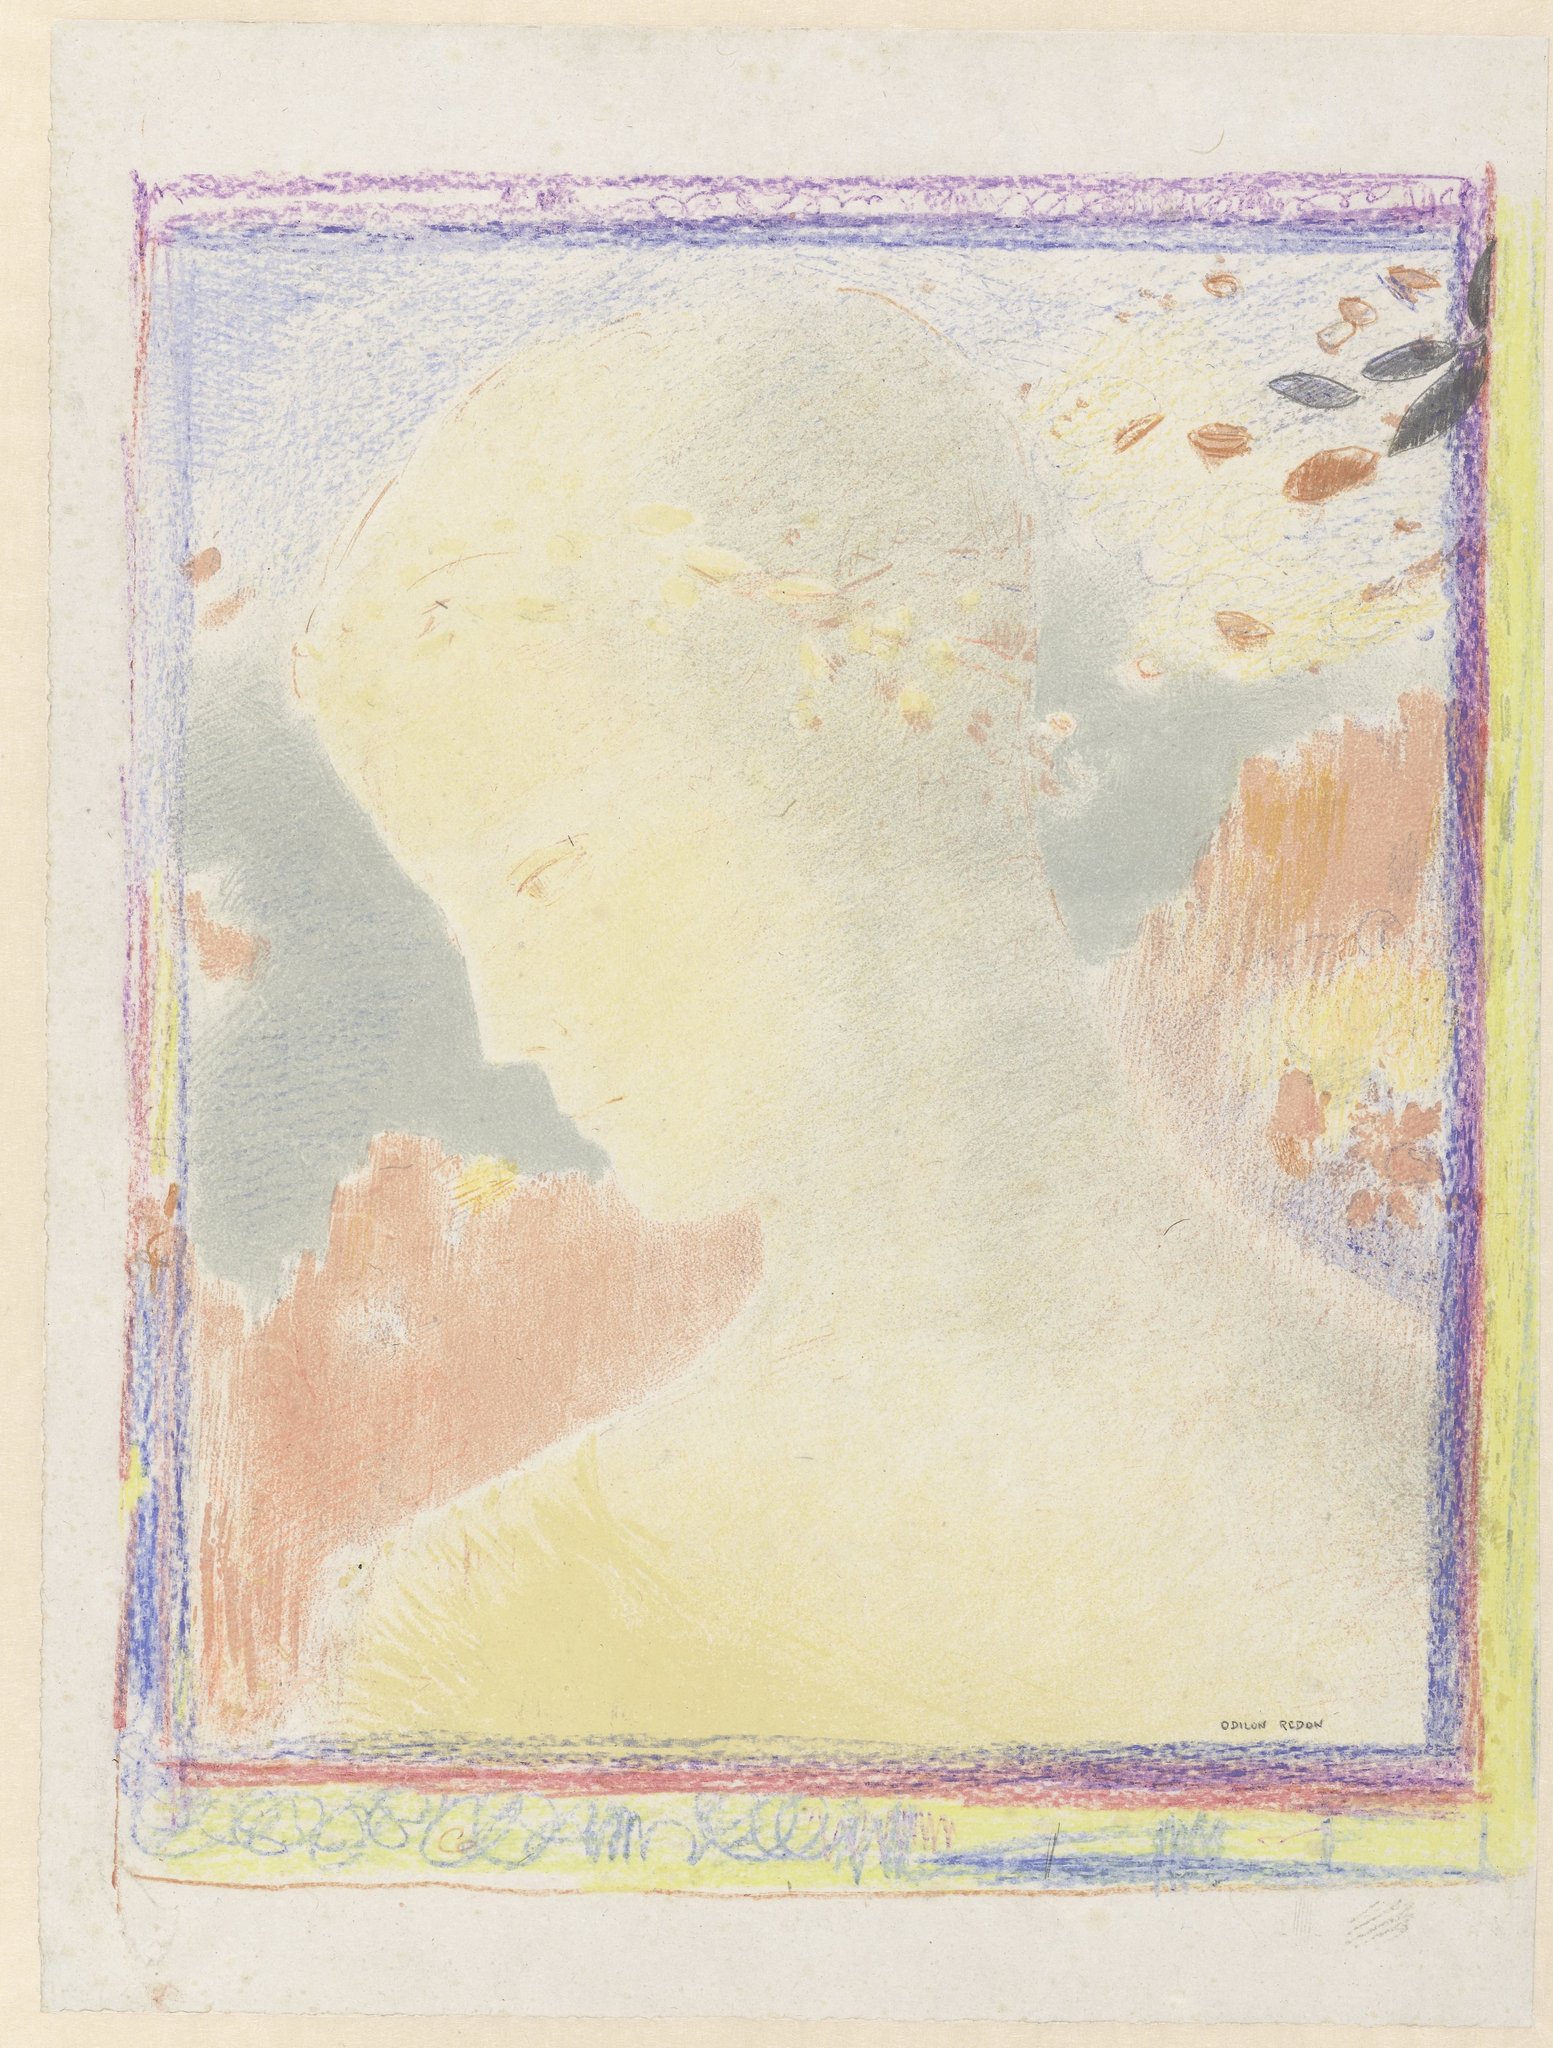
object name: print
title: Beatrice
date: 1897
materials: paper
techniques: printing, hand coloring, lithograph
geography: paris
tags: adult woman (+ sideview, profile)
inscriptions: collector's mark: Lugt 2760, collector's mark: Lugt 2228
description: Eerste staat van een prent gemaakt in opdracht van Ambroise Vollard. De definitieve prent werd één van 32 prenten gemaakt door verschillende kunstenaars, die samen het "Album d'estampes originales de la Galerie Vollard" vormden. Dit album werd door Vollard uitgegeven in december 1897.